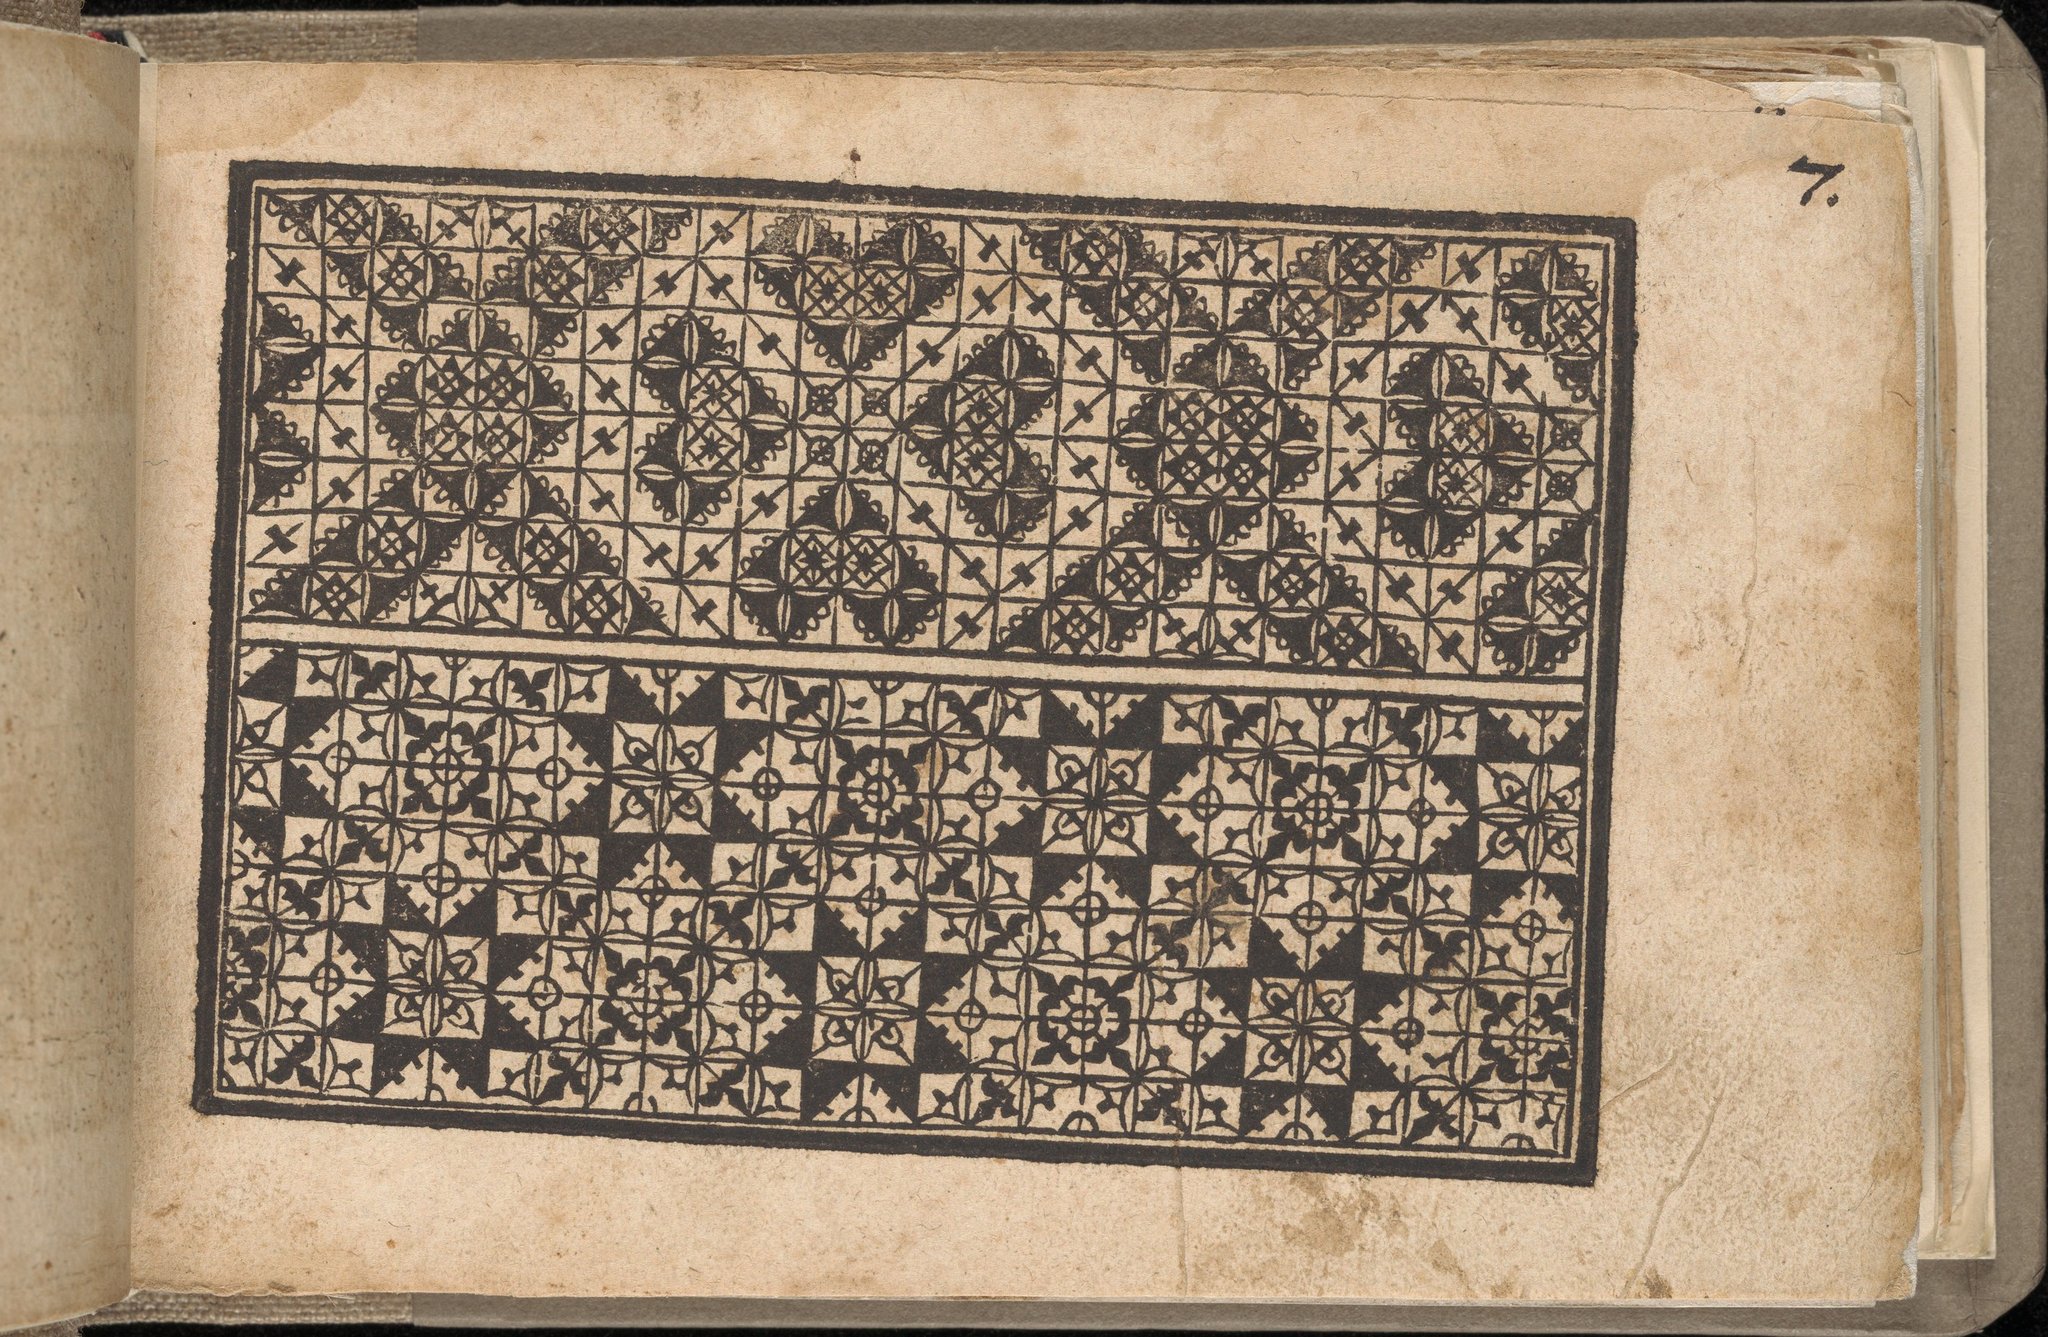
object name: book print ornament architecture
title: Schön newes Modelbuch (Page 7r)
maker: sigismundus latomus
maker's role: publisher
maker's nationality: german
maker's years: 1599-1632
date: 1608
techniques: woodcut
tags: ornament